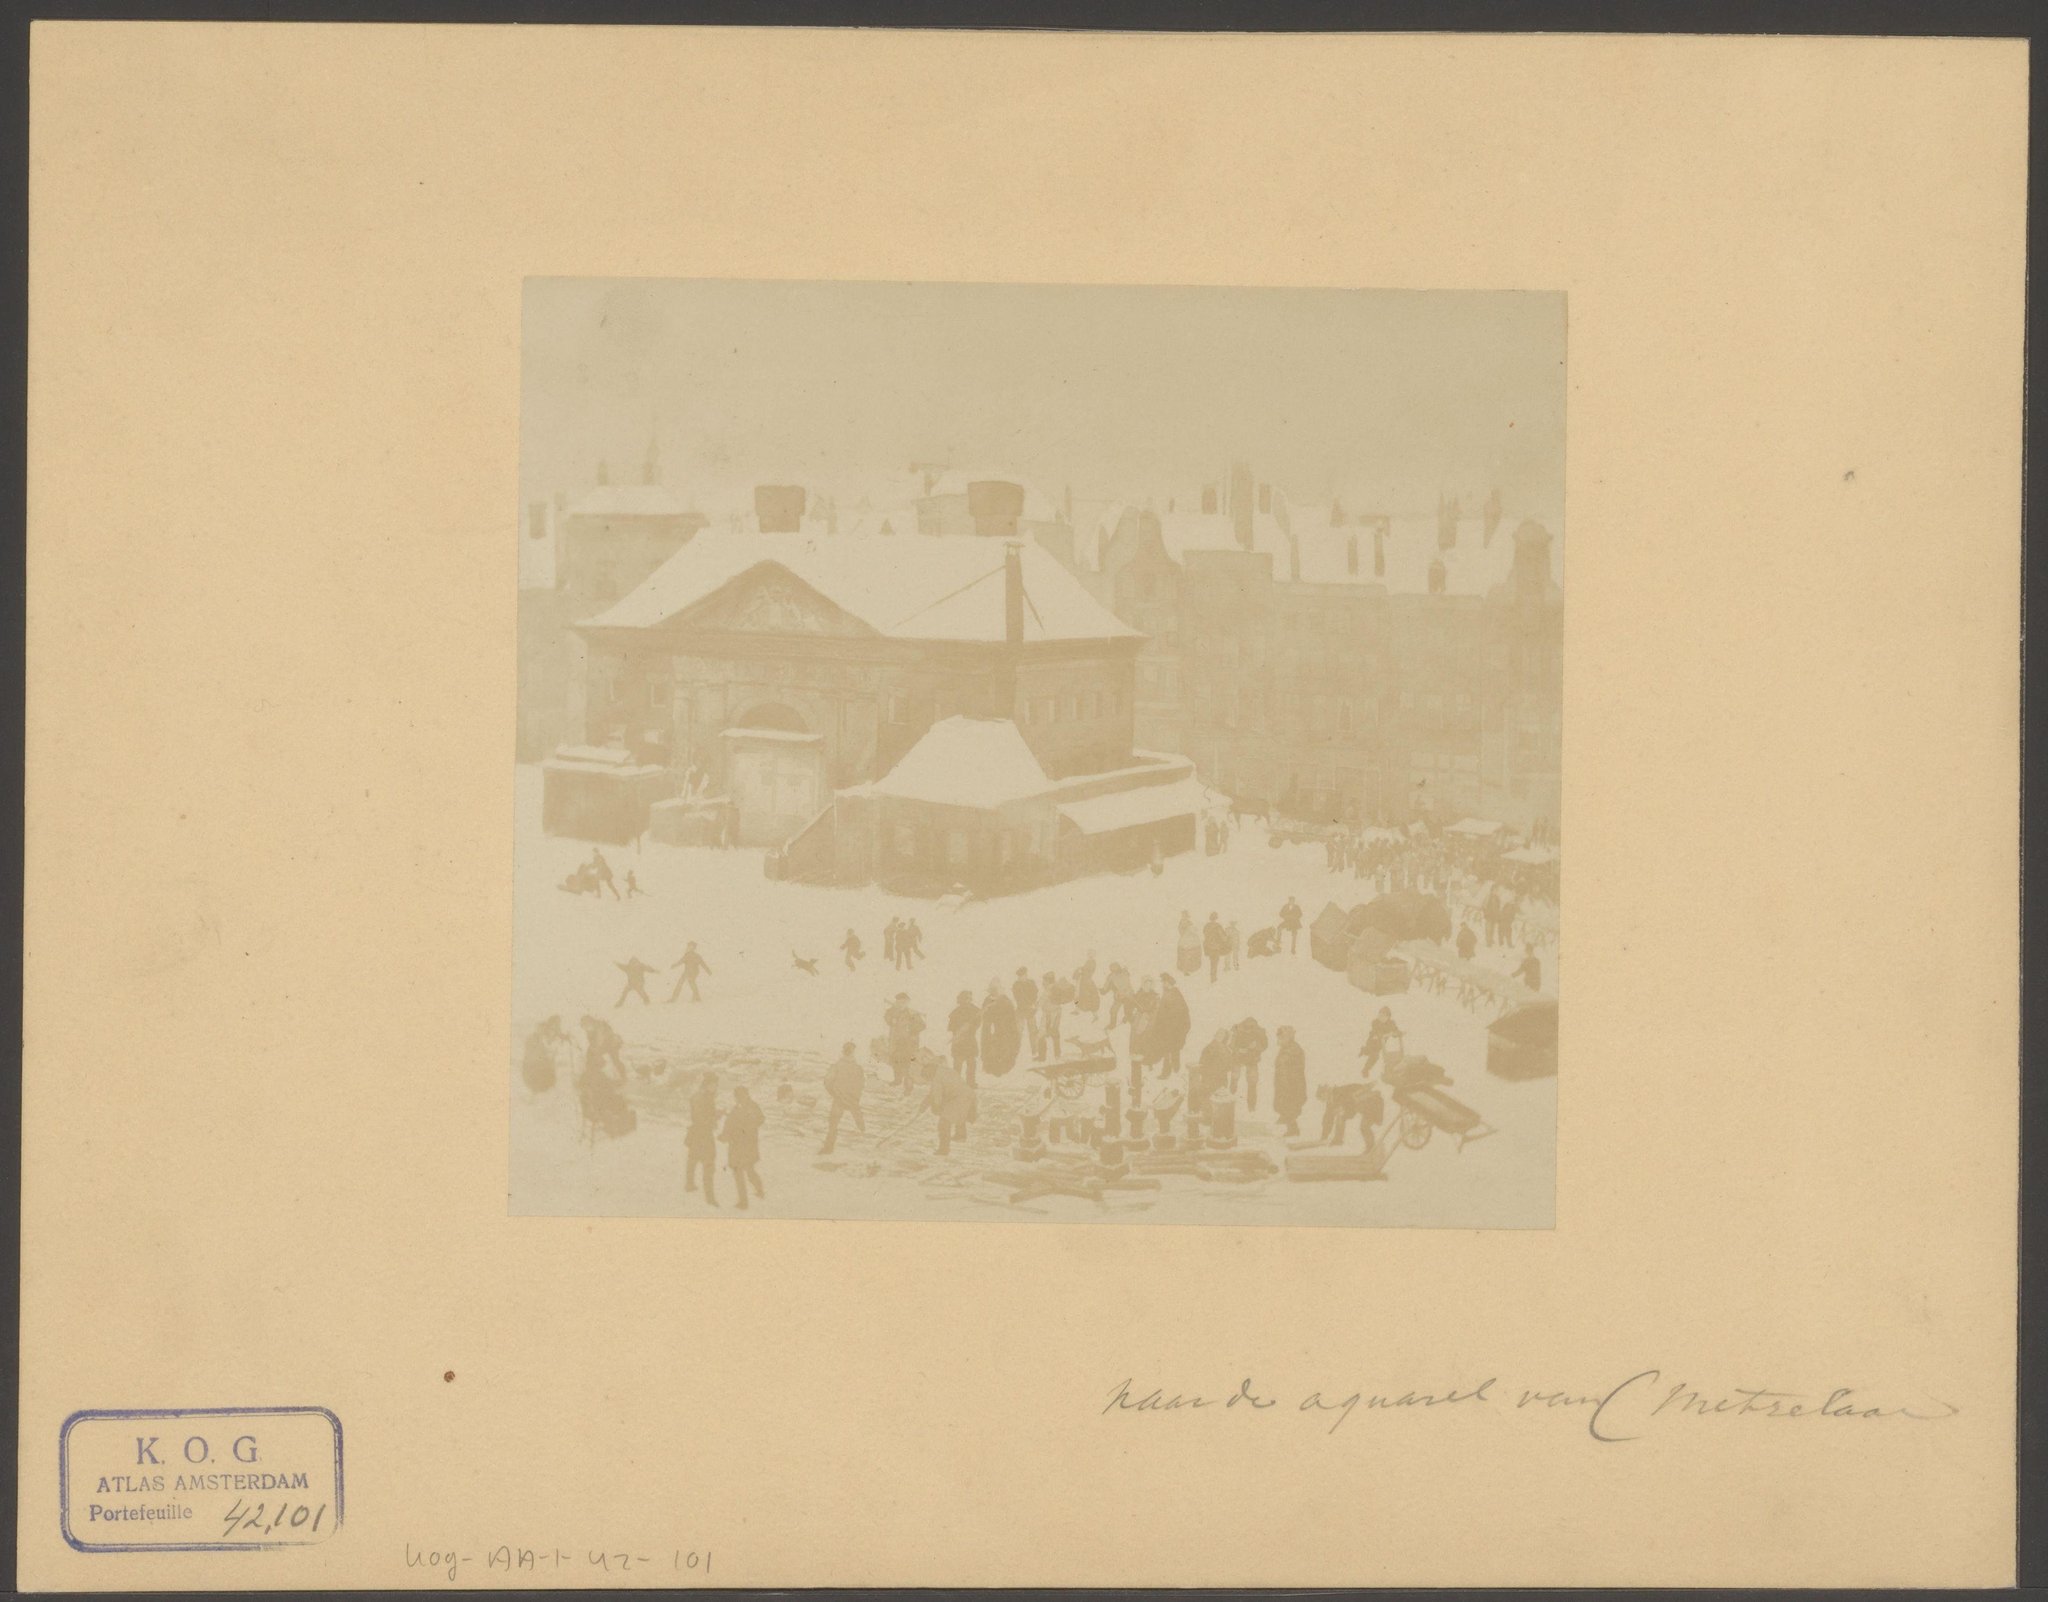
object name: photograph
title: Waag op de Botermarkt in de sneeuw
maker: Anonymous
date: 1860-1900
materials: paper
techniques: albumen print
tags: weigh-house, amsterdam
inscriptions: collector's mark: Lugt 1641b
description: Onderwerpsrubriek binnen de Atlas Amsterdam: Markten, handel: C. Veemen, Waaggebouwen.